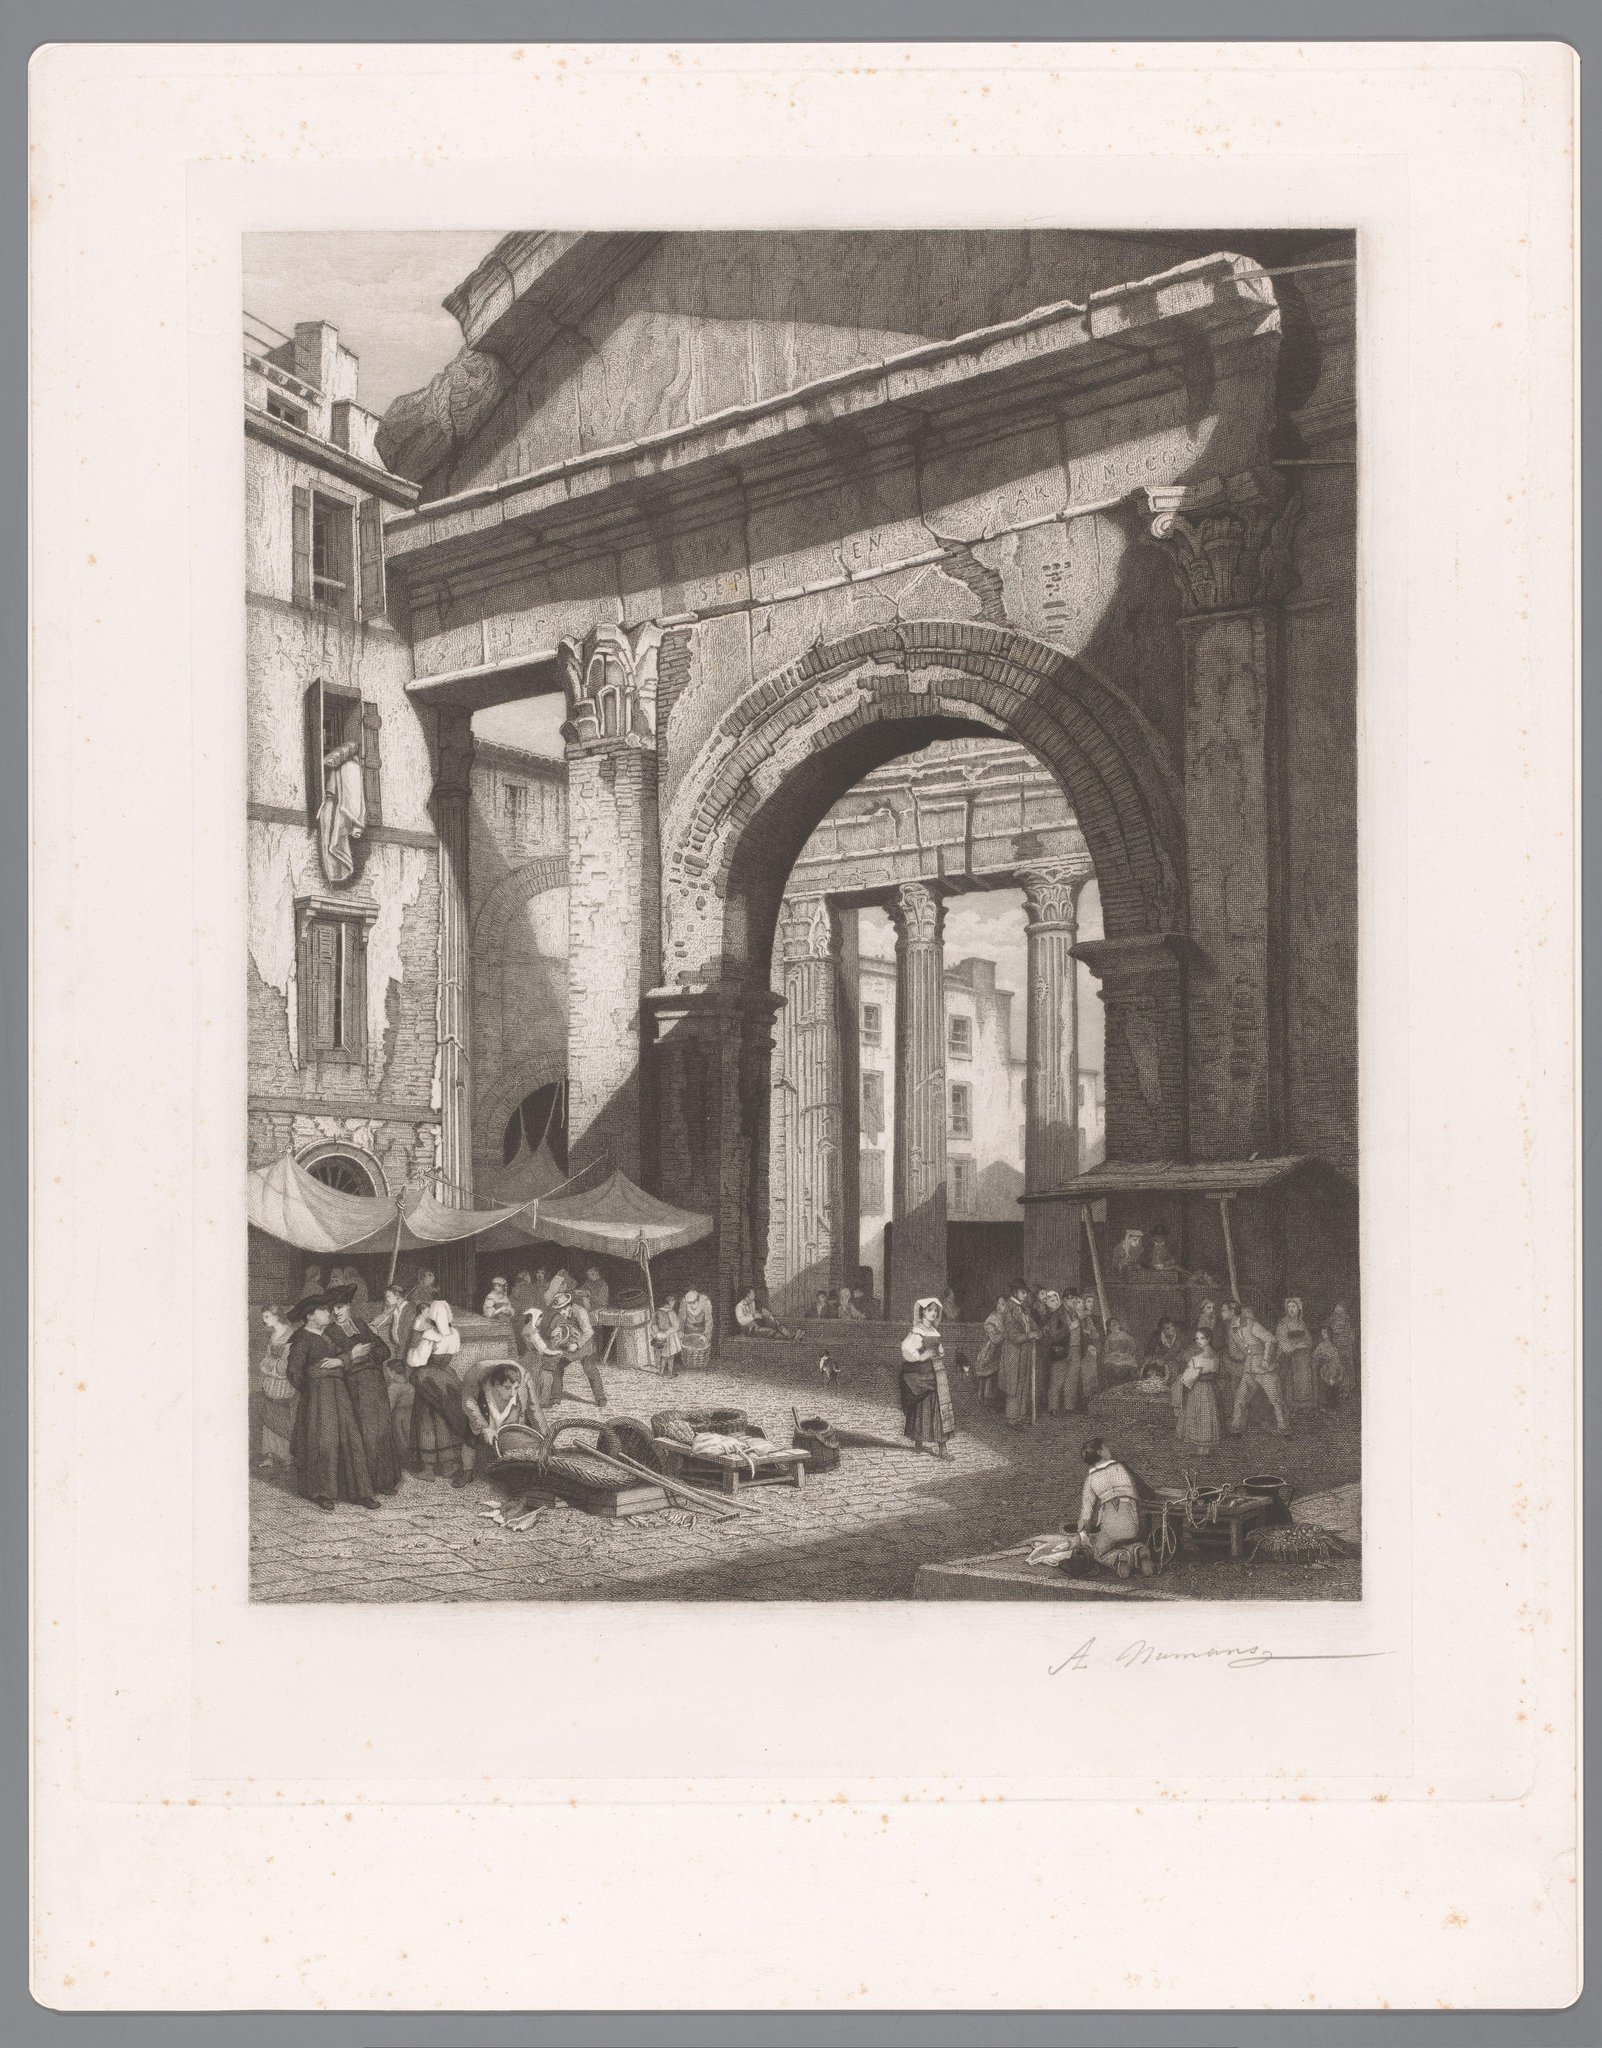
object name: print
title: Gezichten door Auguste Numans naar andere kunstenaars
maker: auguste numans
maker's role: print maker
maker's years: 1823-1883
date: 1833-1883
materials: paper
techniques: etching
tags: monumental door, porch, 'aediculum', ruin of a building ~ architecture, market, rome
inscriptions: collector's mark: Lugt 2228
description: Prent behoort tot de prentserie: Dix eaux-fortes par A. Numans. Bij Hippert&Linnig wordt gesproken over een titelprent met de titel 'Six eaux-fortes (...)'. Waarschijnlijk gaat het om dezelfde prent als RP-P-1913-2243 want in de letter 'D' zijn contouren van een letter 'S' te zien. Mogelijk is de titelprent later aangepast om de prentserie uit te breiden van zes naar tien prenten.